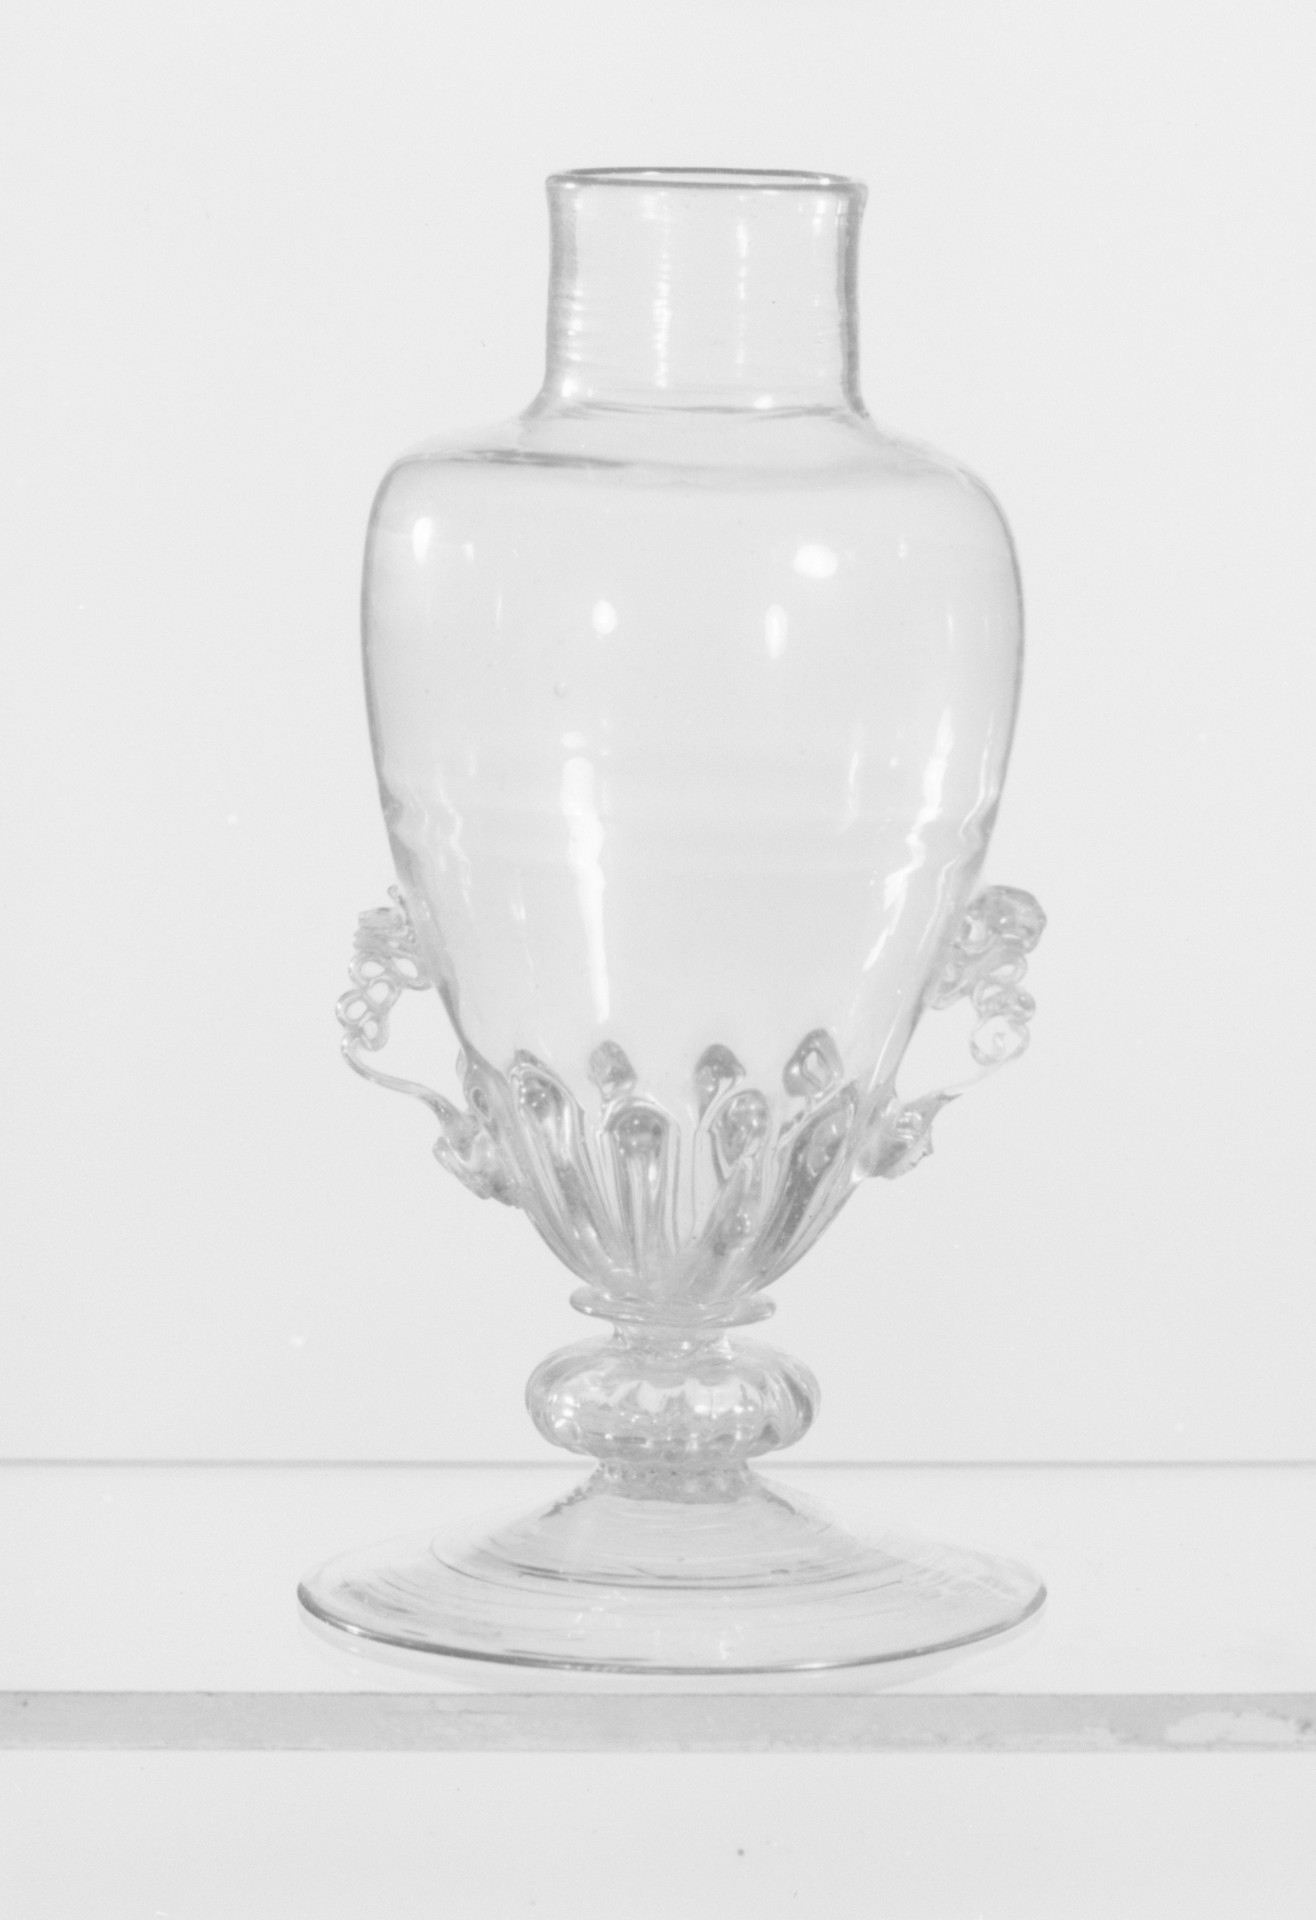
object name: vase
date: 1501-1700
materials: glass